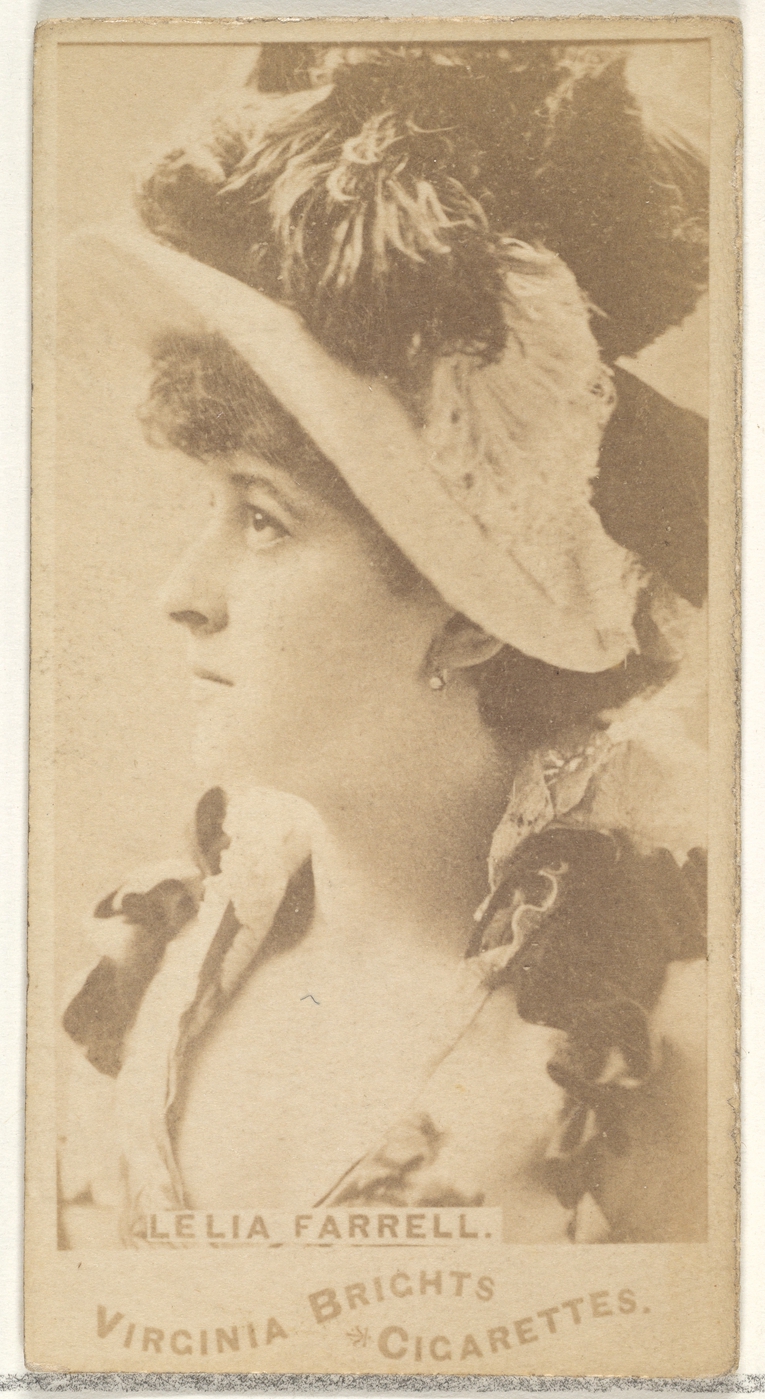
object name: photograph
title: Leila Farrell, from the Actors and Actresses series (N45, Type 1) for Virginia Brights Cigarettes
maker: allen & ginter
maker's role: publisher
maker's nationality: american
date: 1888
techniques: albumen silver print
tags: portraits,profiles,women,actresses